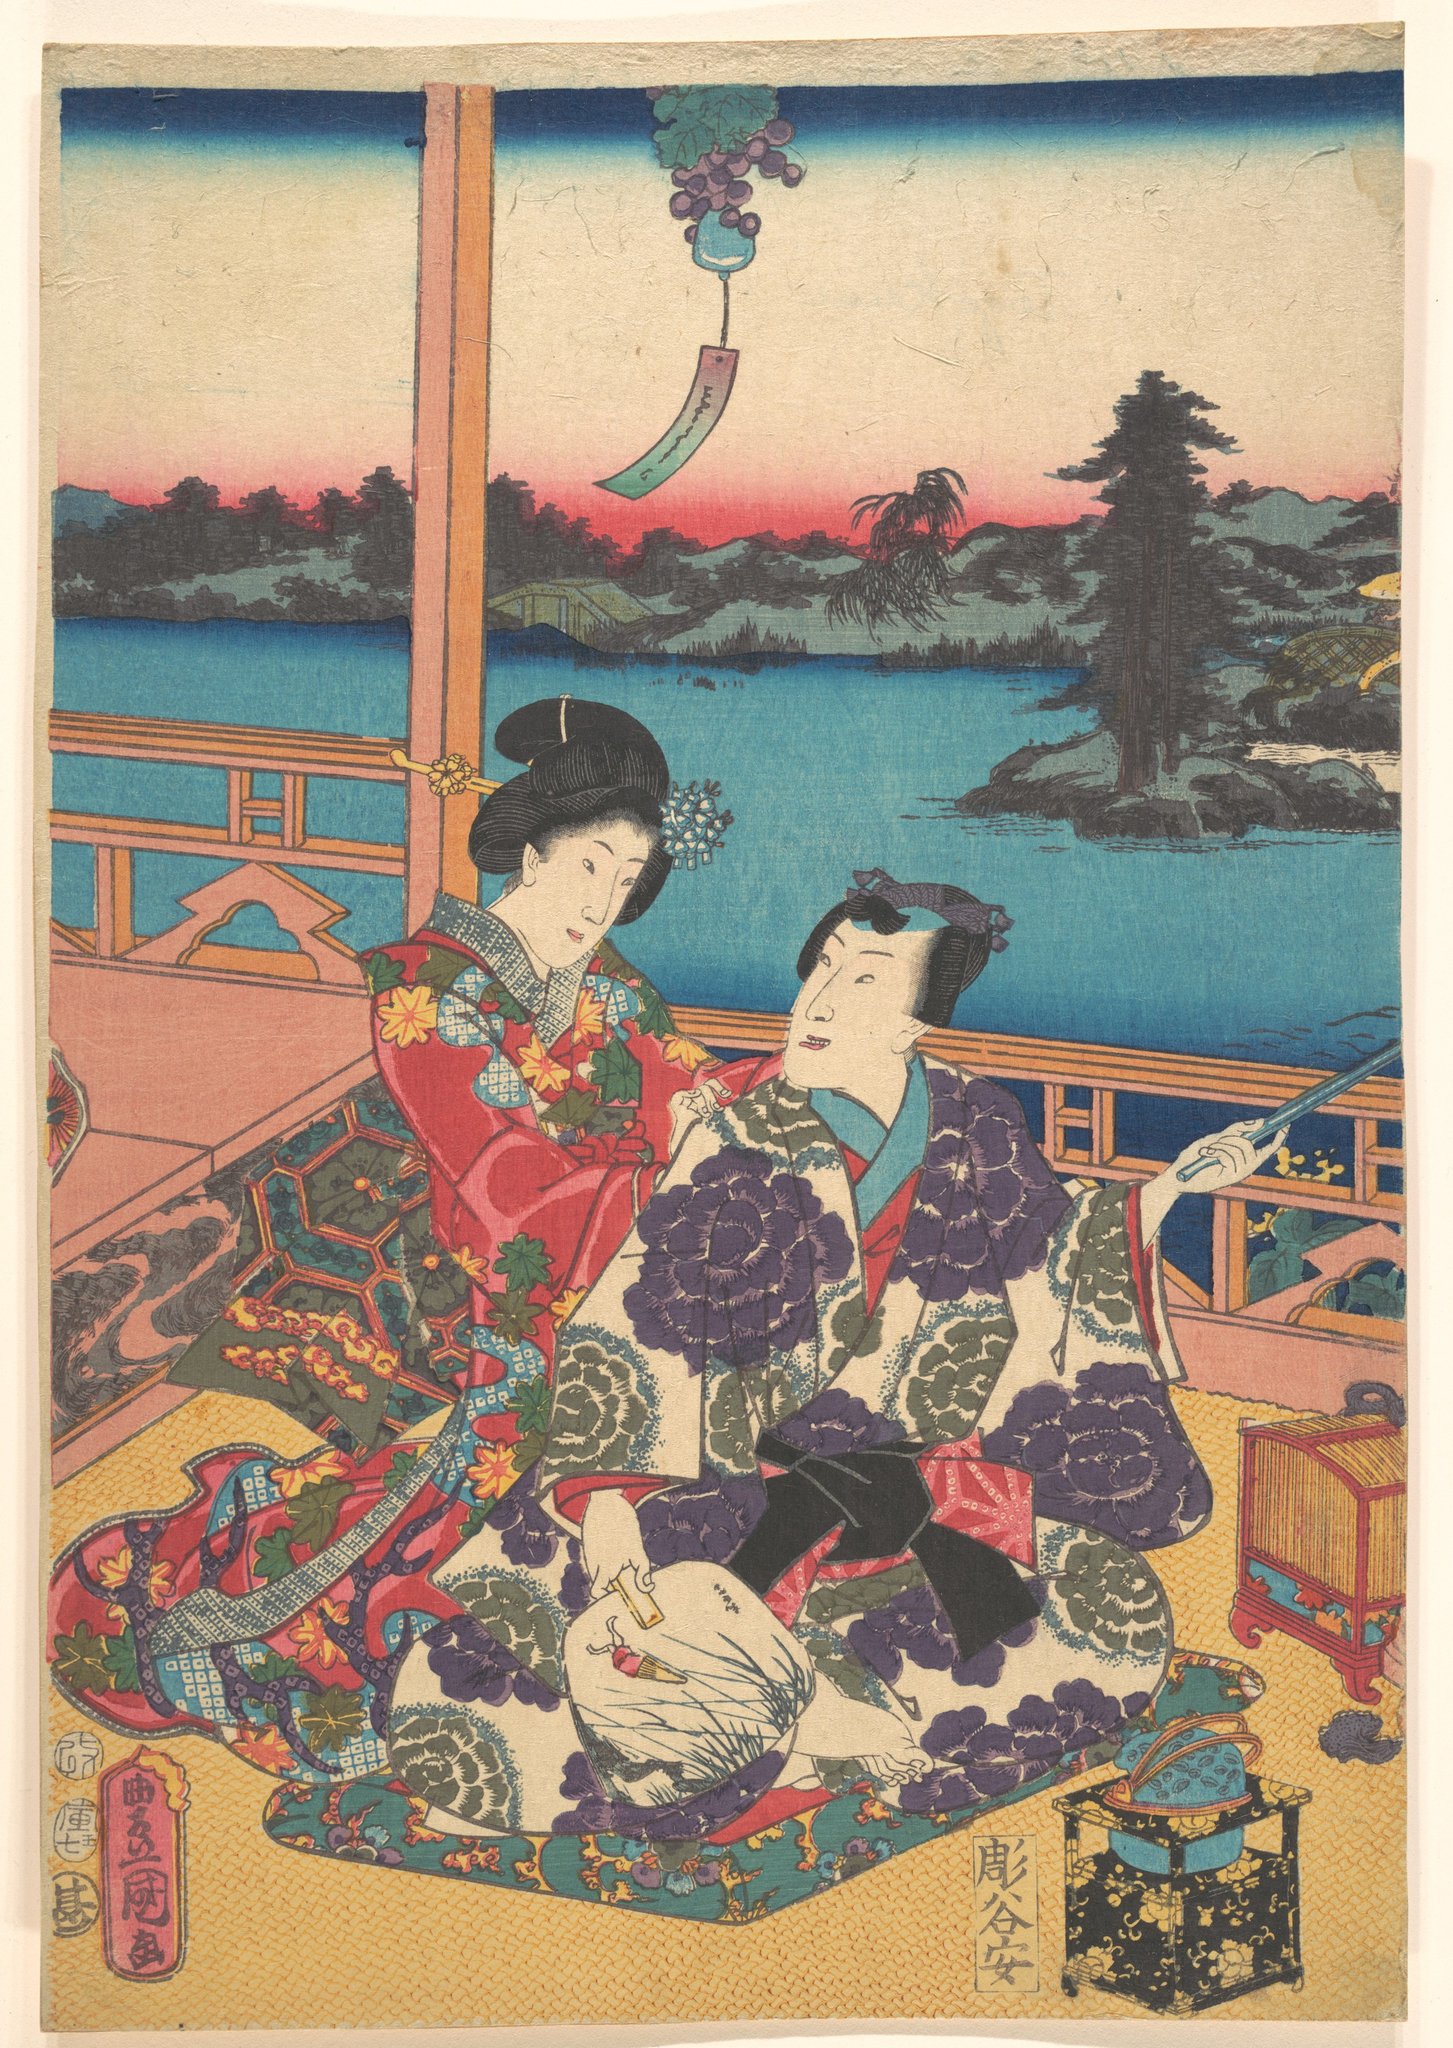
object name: print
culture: japanese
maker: utagawa kunisada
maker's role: artist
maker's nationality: japanese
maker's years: 1786-1864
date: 1786-1854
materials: ink, paper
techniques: woodblock print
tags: men,women